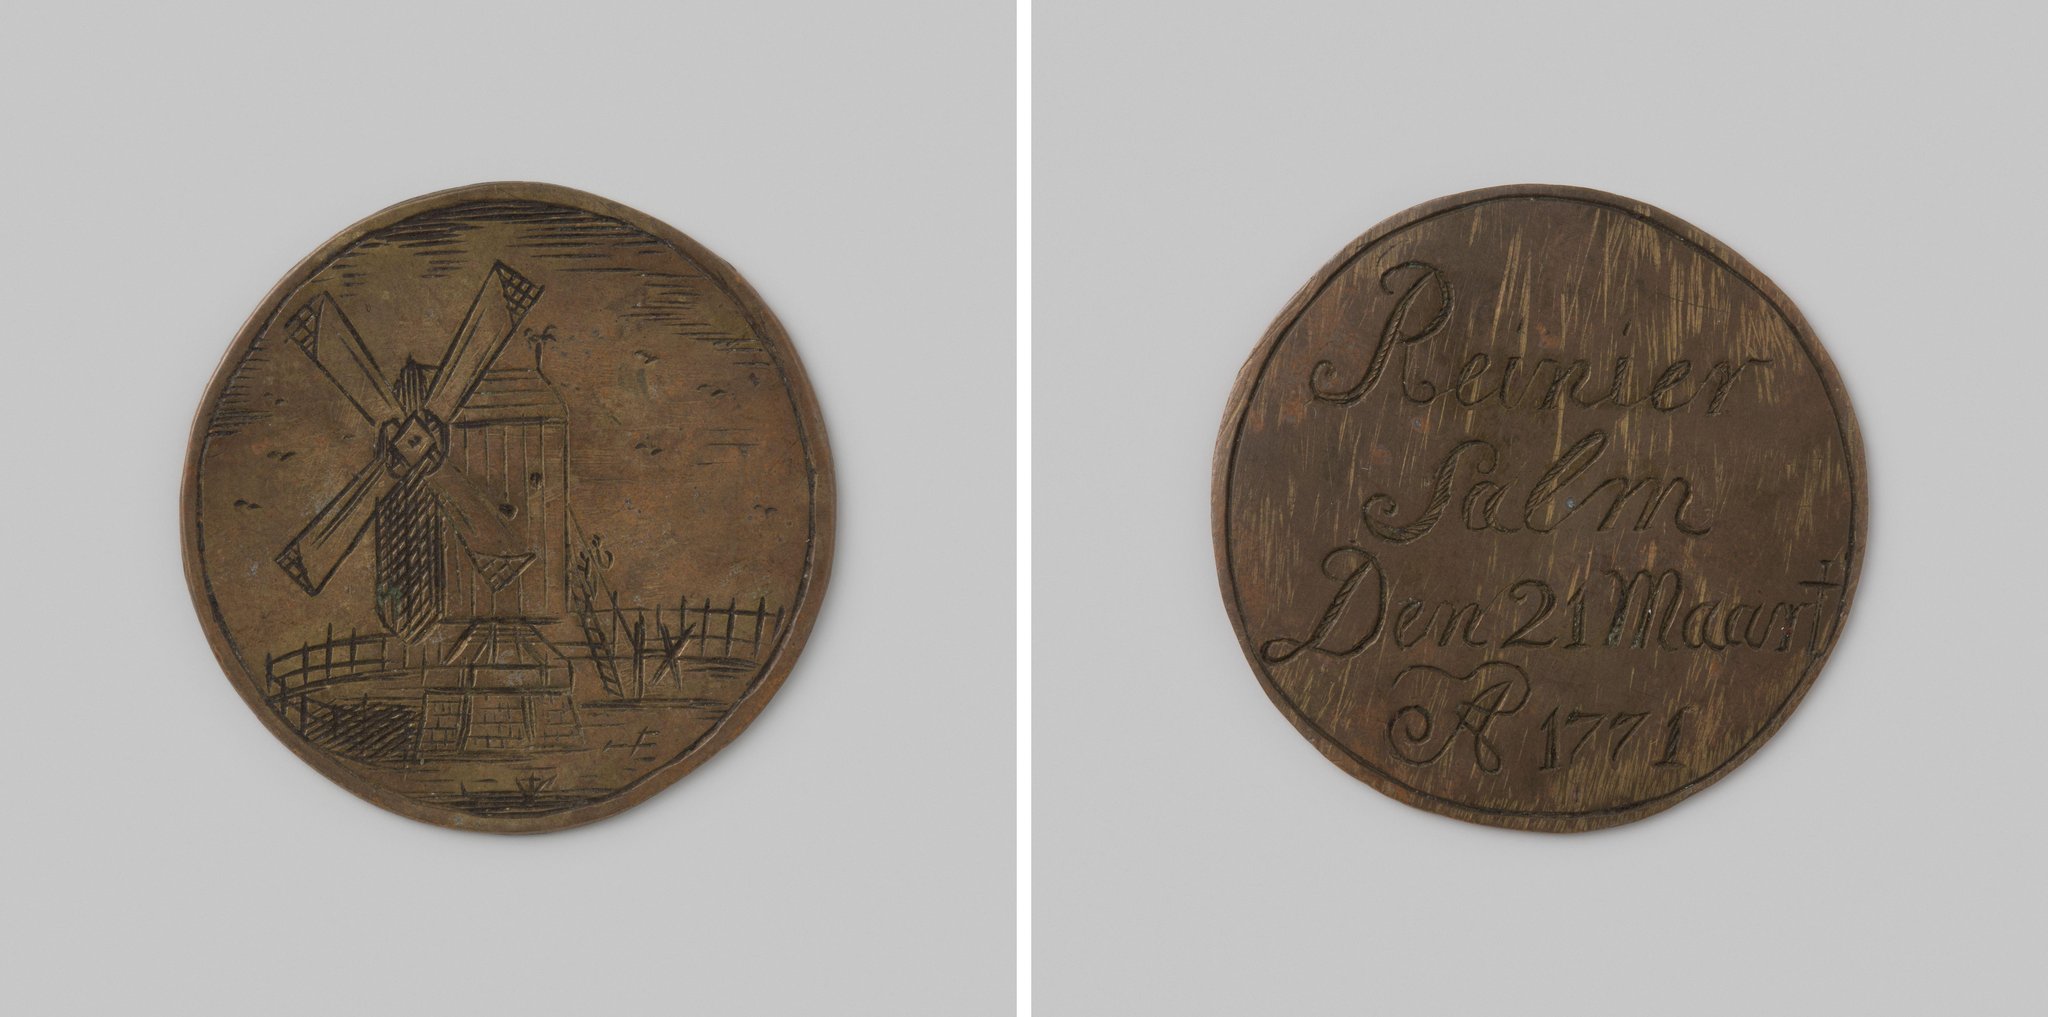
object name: medal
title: Presentiepenning van het Korenmolenaarsgilde te Amsterdam 1683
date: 1683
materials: brass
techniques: engraving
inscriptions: inscription: ‘Reinier / Salm / Den 21 Maart / A 1771’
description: Ronde plaat messing gegraveerd op de voorzijde een windmolen binnen omheining, op de keerzijde tekst, op naam van Reinier Salm 21 maart 1771